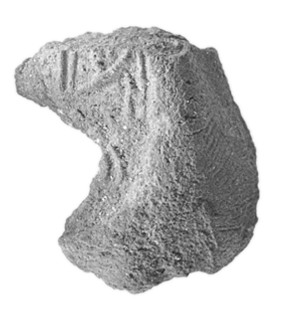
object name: sealing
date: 2030-1640 BCE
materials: clay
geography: egypt